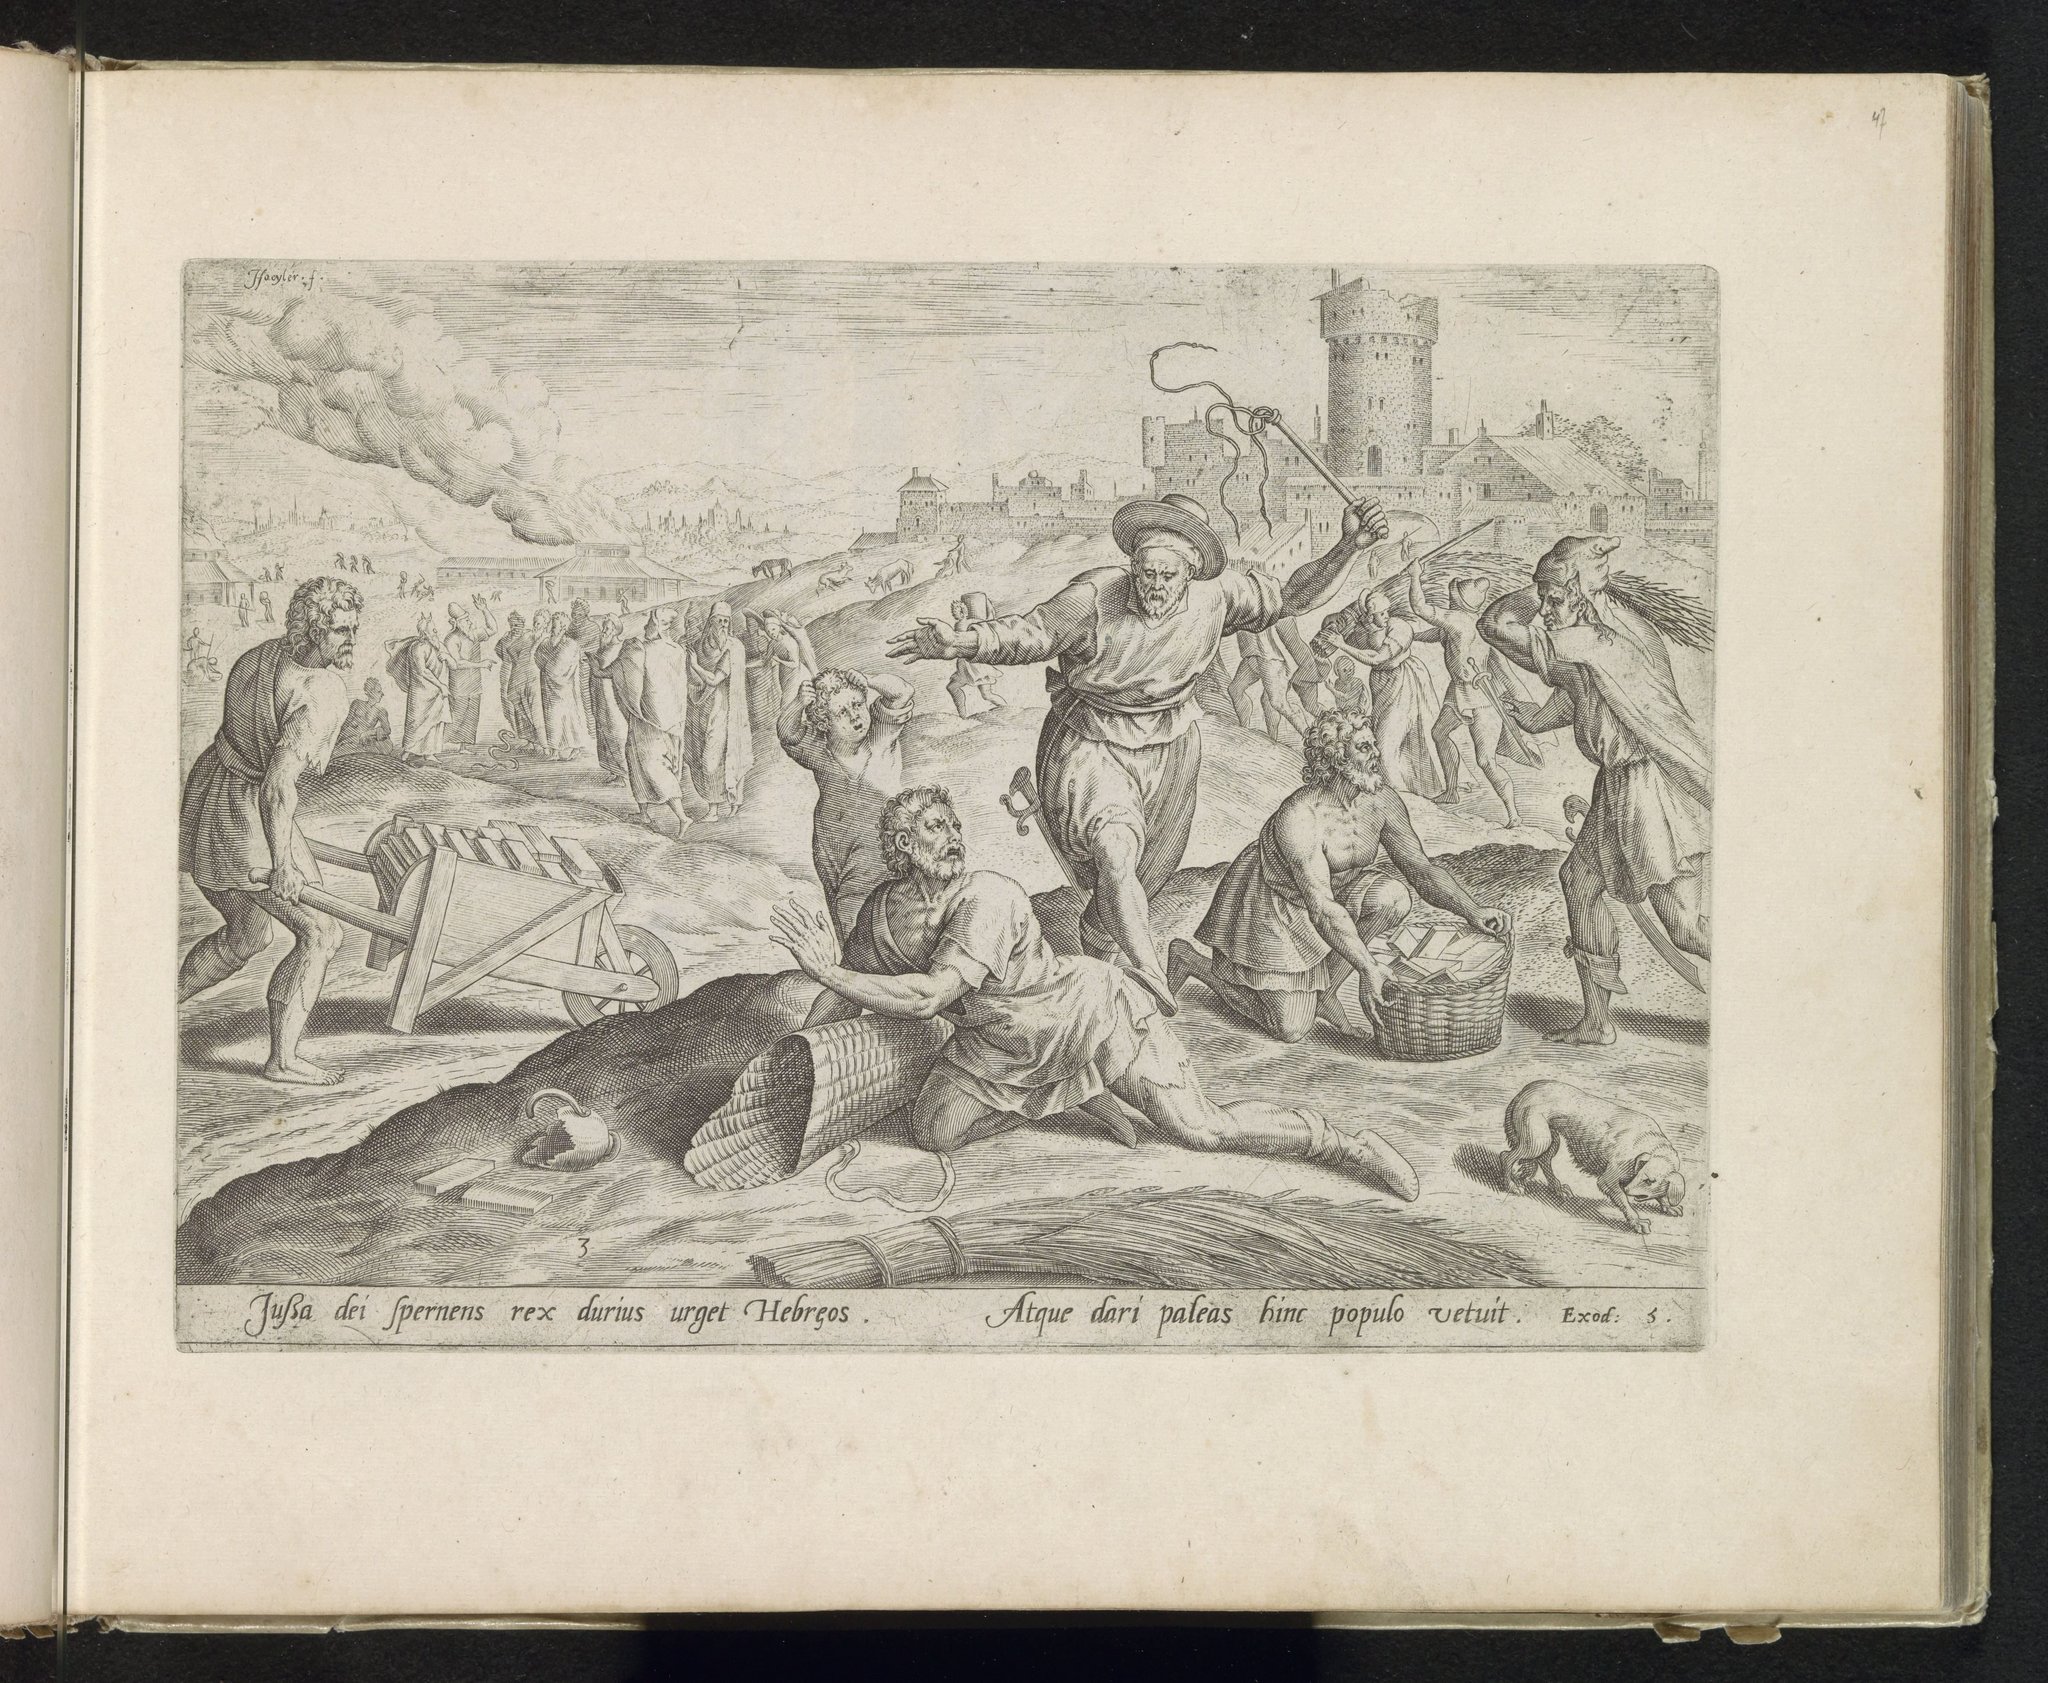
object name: album leaf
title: Mishandeling van de Israëlieten door de Egyptenaren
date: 1585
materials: paper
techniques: engraving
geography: antwerp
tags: the israelites complain to moses and aaron (~ pharaoh), pharaoh commands the taskmasters to stop supplying the people with straw for making bricks (+ variant)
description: Een Israëlitische arbeider valt op de grond en wordt door een van de Egyptische opzichters van de farao met een zweep geslagen. De Israëlieten verzamelen stro voor het bakken van stenen. Op de achtergrond preken Mozes en Aäron. Onder de voorstelling een verwijzing in het Latijn naar de Bijbeltekst in Ex. 5. Deze prent maakt deel uit van een album.